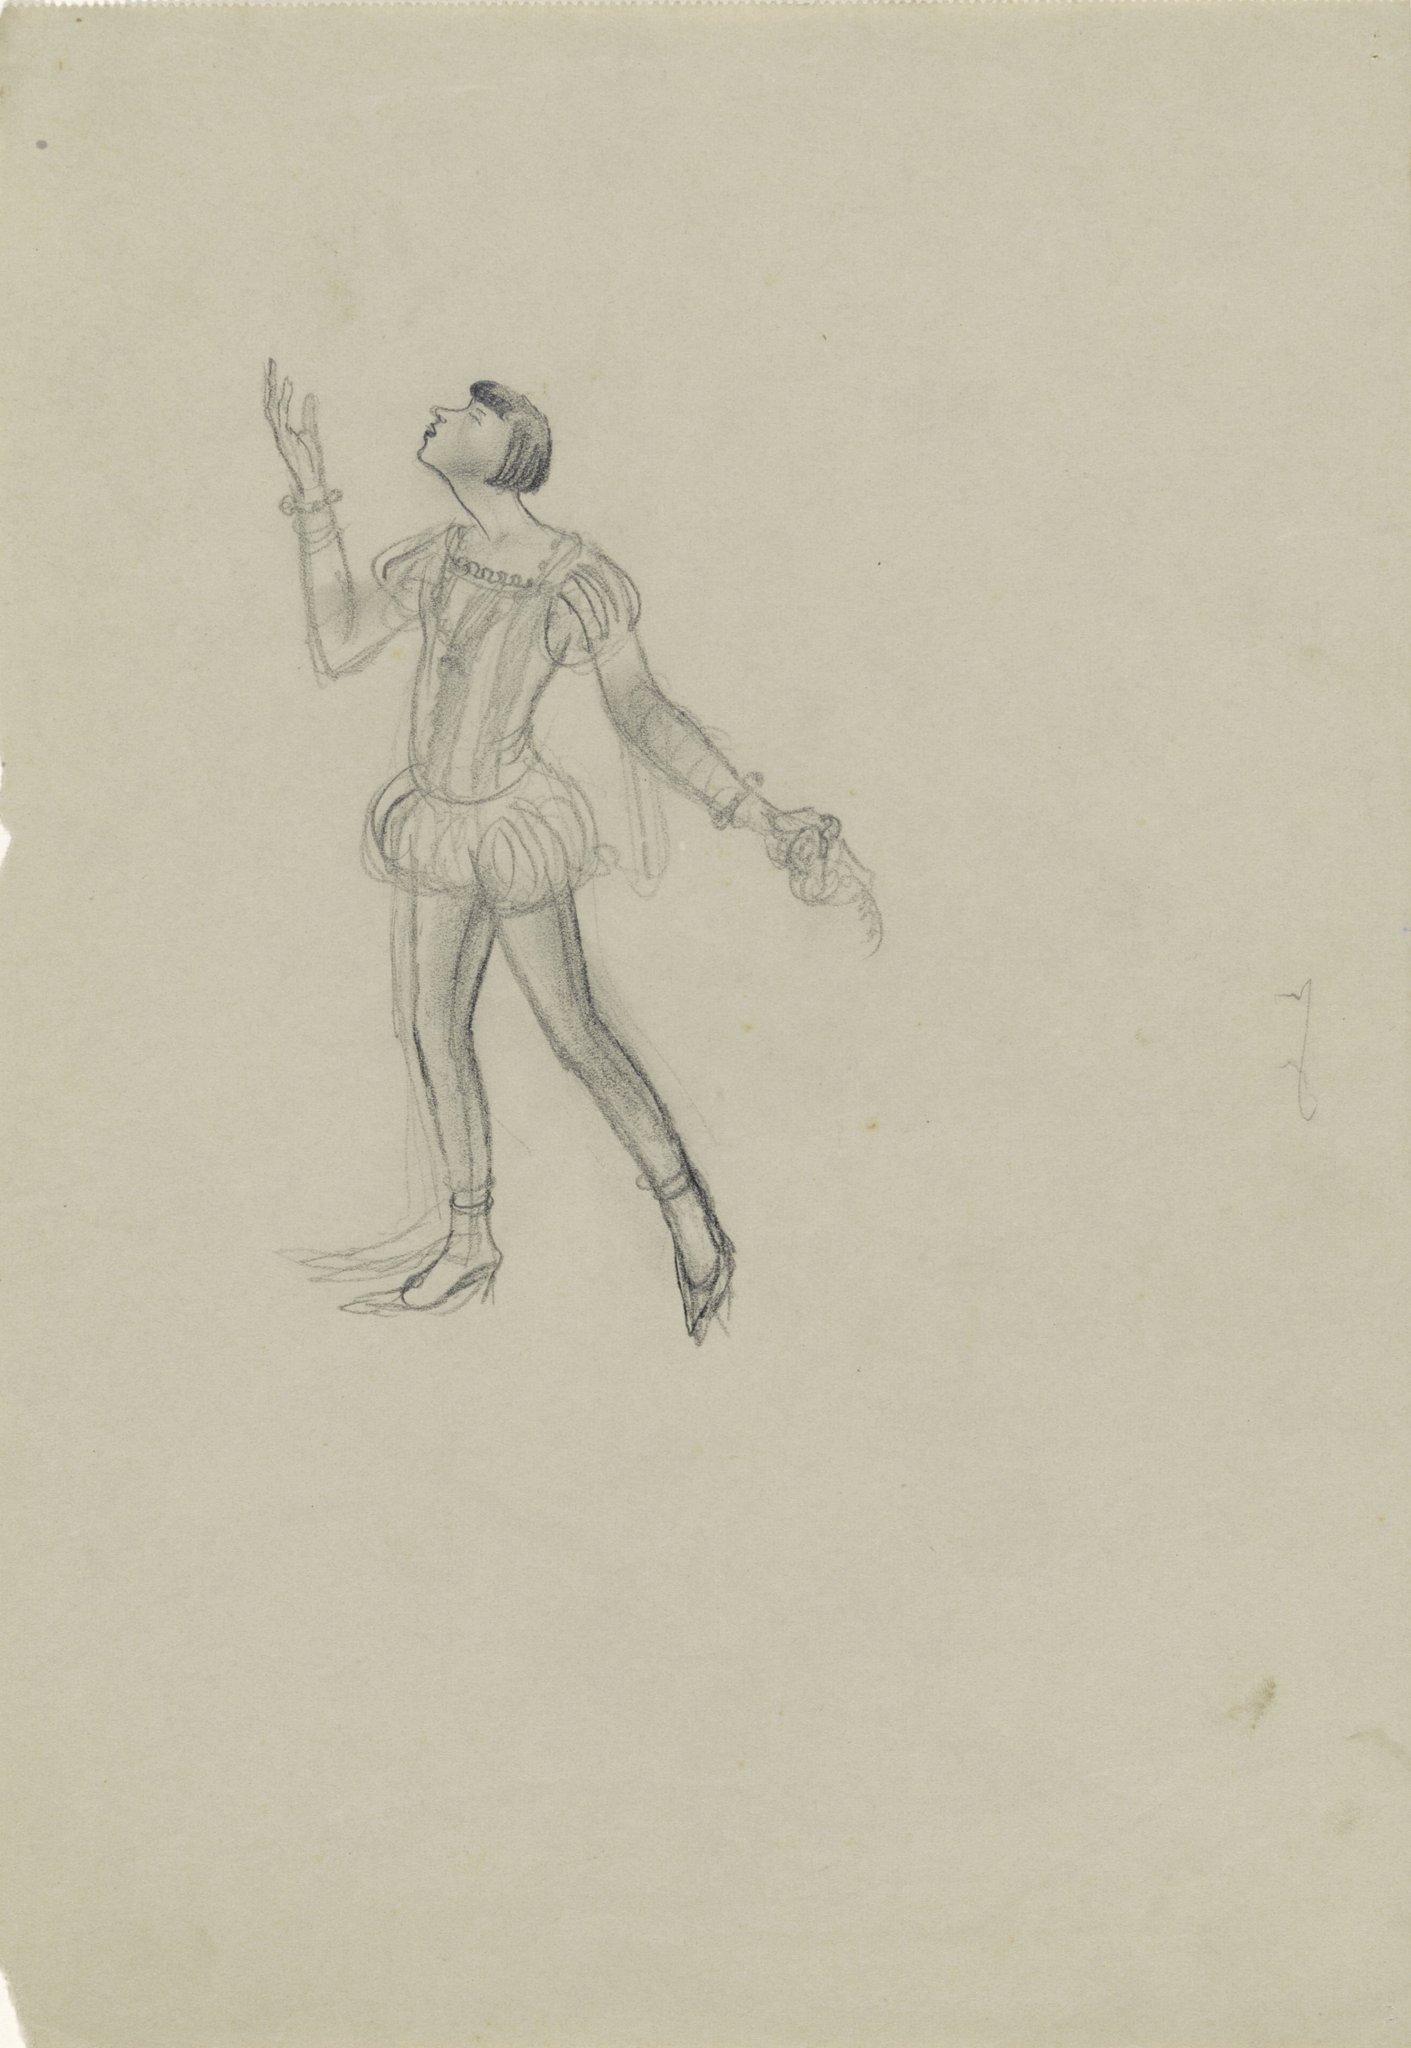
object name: drawing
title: Staande figuur op hakken met in zijn linkerhand zijn hoed, terwijl hij zijn rechterhand omhoog houdt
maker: henk henriët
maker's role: draughtsman, print maker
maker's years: 1903-1945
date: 1936-1940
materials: paper, pencil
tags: standing figure, head-gear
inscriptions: collector's mark: Lugt 2228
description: Deze tekening is mogelijk een ontwerp voor een illustratie bij het boek 'Gargantua en Pantagruel' van François Rabelais.